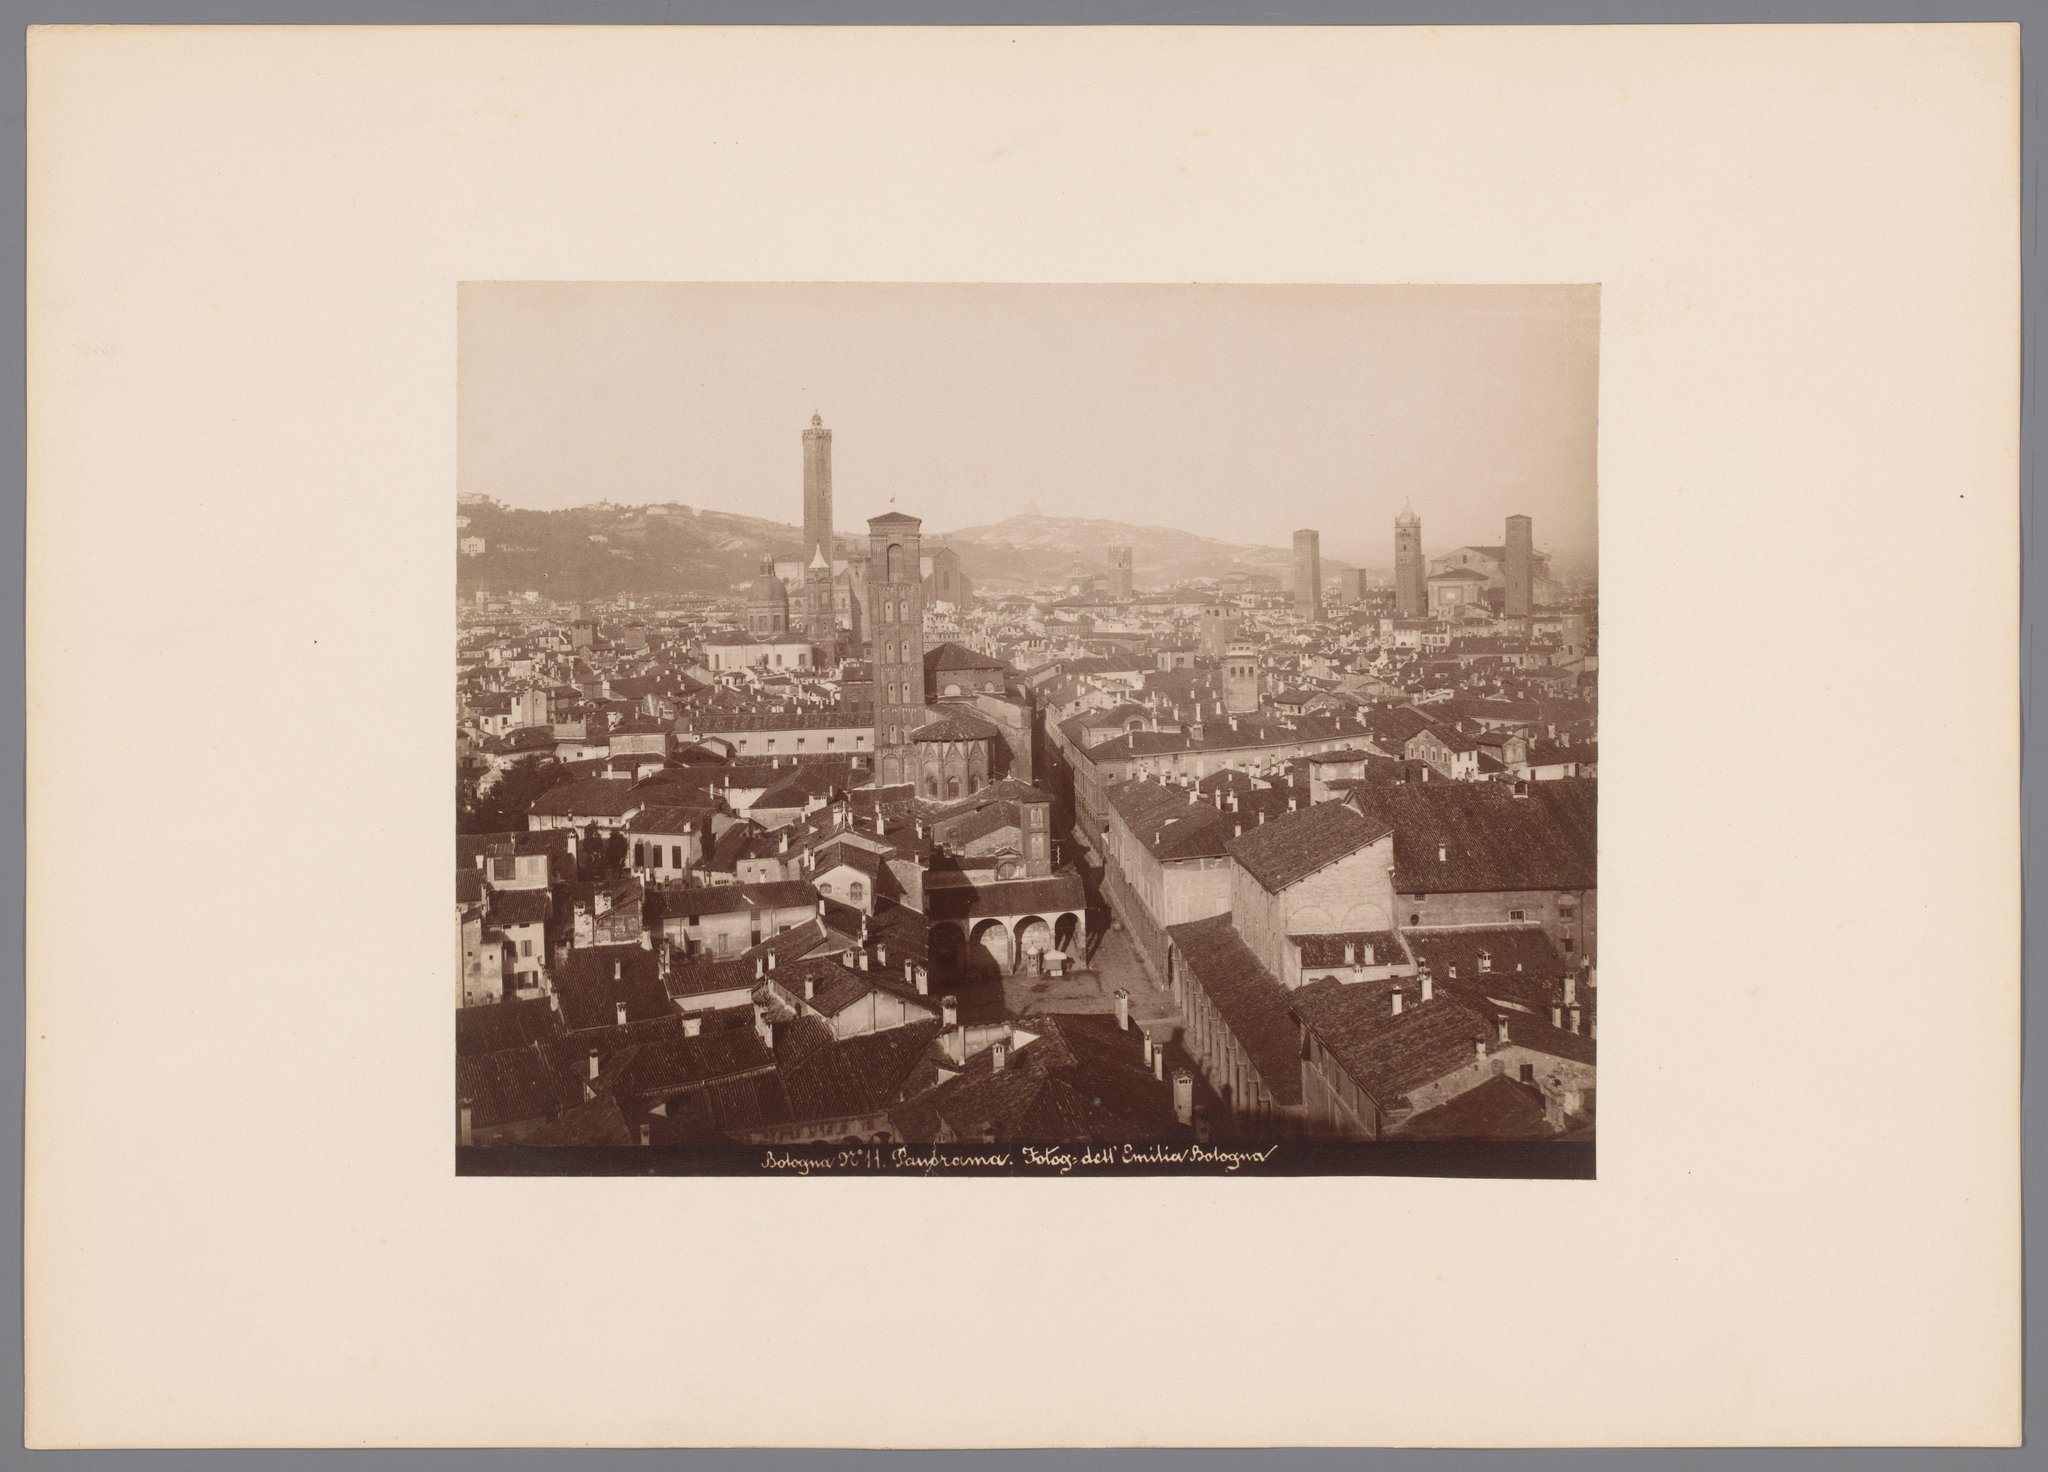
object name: photograph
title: Bologna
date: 1865-1907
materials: cardboard, paper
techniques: albumen print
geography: bologna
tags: city-view in general; 'veduta'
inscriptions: number: ‘73’, number: ‘No.11.’